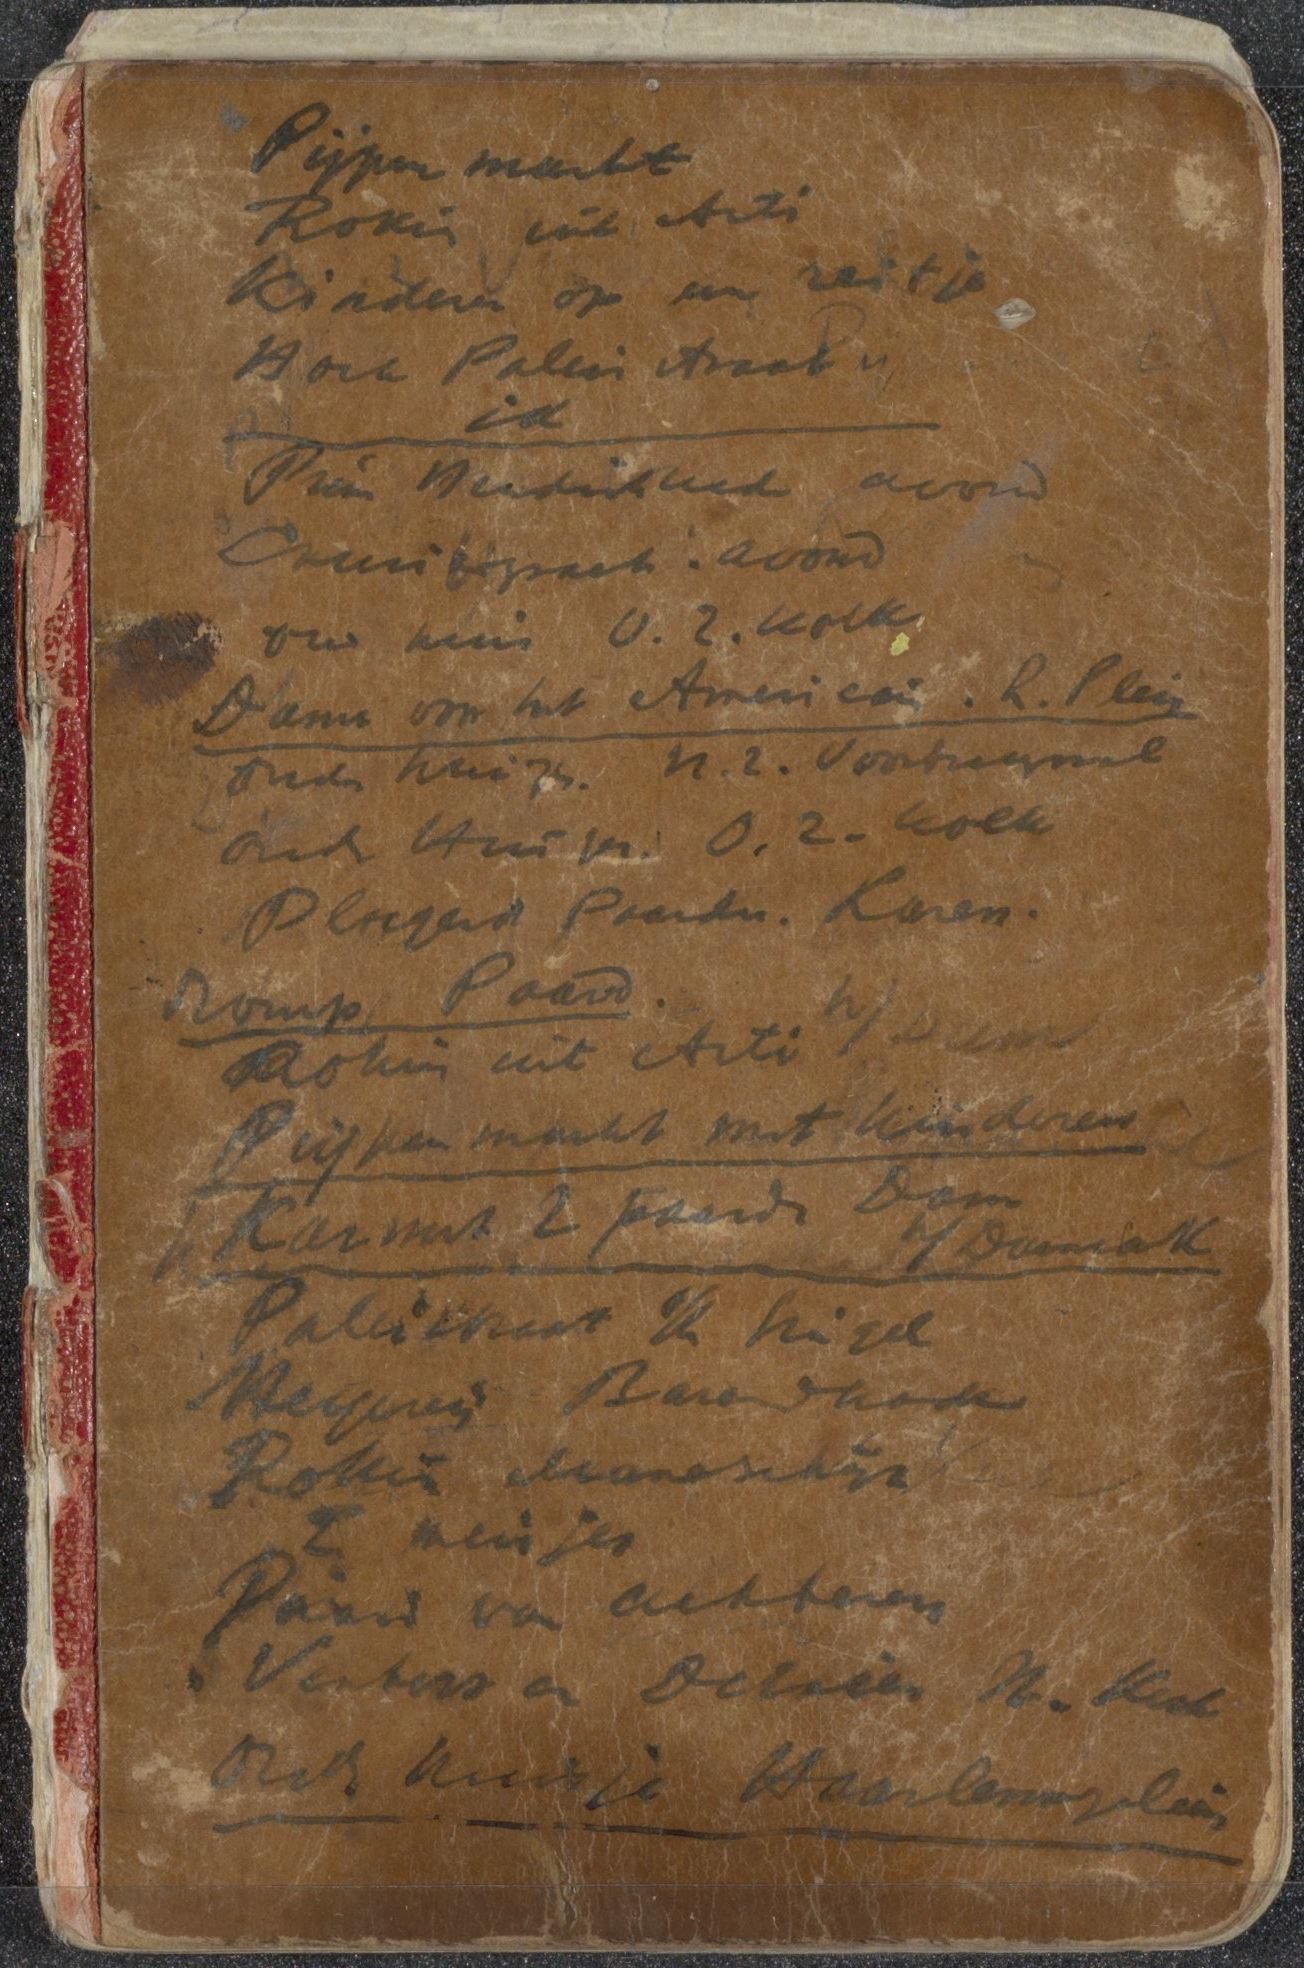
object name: sketchbook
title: Schetsboek met 37 bladen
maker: george hendrik breitner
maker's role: draughtsman, painter, print maker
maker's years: 1857-1923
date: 1896-1901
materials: cardboard, chalk, linen, paper, pencil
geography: amsterdam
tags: civic architecture; edifices; dwellings, street, amsterdam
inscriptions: annotation: ‘Pijpen markt/ Rokin uit Arti/ Kinderen op een reitje/ Hoek Paleisstraat Pijpenmarkt/ id/ Prins Hendrikkade avond/ Lauriergracht avond/ oud huis O.Z. Kolk/ Dam voor het Americain. L. Plein/ oude huisjes. N.Z. Voorburgwal/ oude huisjes O.Z. Kolk/ Ploegend paarden. Koren[?]/ romp paard/ Rokin uit Arti h/ Dam/ Pijpen markt met kinderen/ Kar met 2 paarden Dam/ h/ Damrak/ Paleisstraat b/h Singel/ Heijereij[?] Barendkade [sic]/ Rokin maneschijn/ 2 meisjes/ Paard van achteren/ Vensters en De[...] N. Kerk/ oud huisje Haarlemmerplein’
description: Schetsboek bestaande uit 37 bladen met voornamelijk gezichten te Amsterdam.